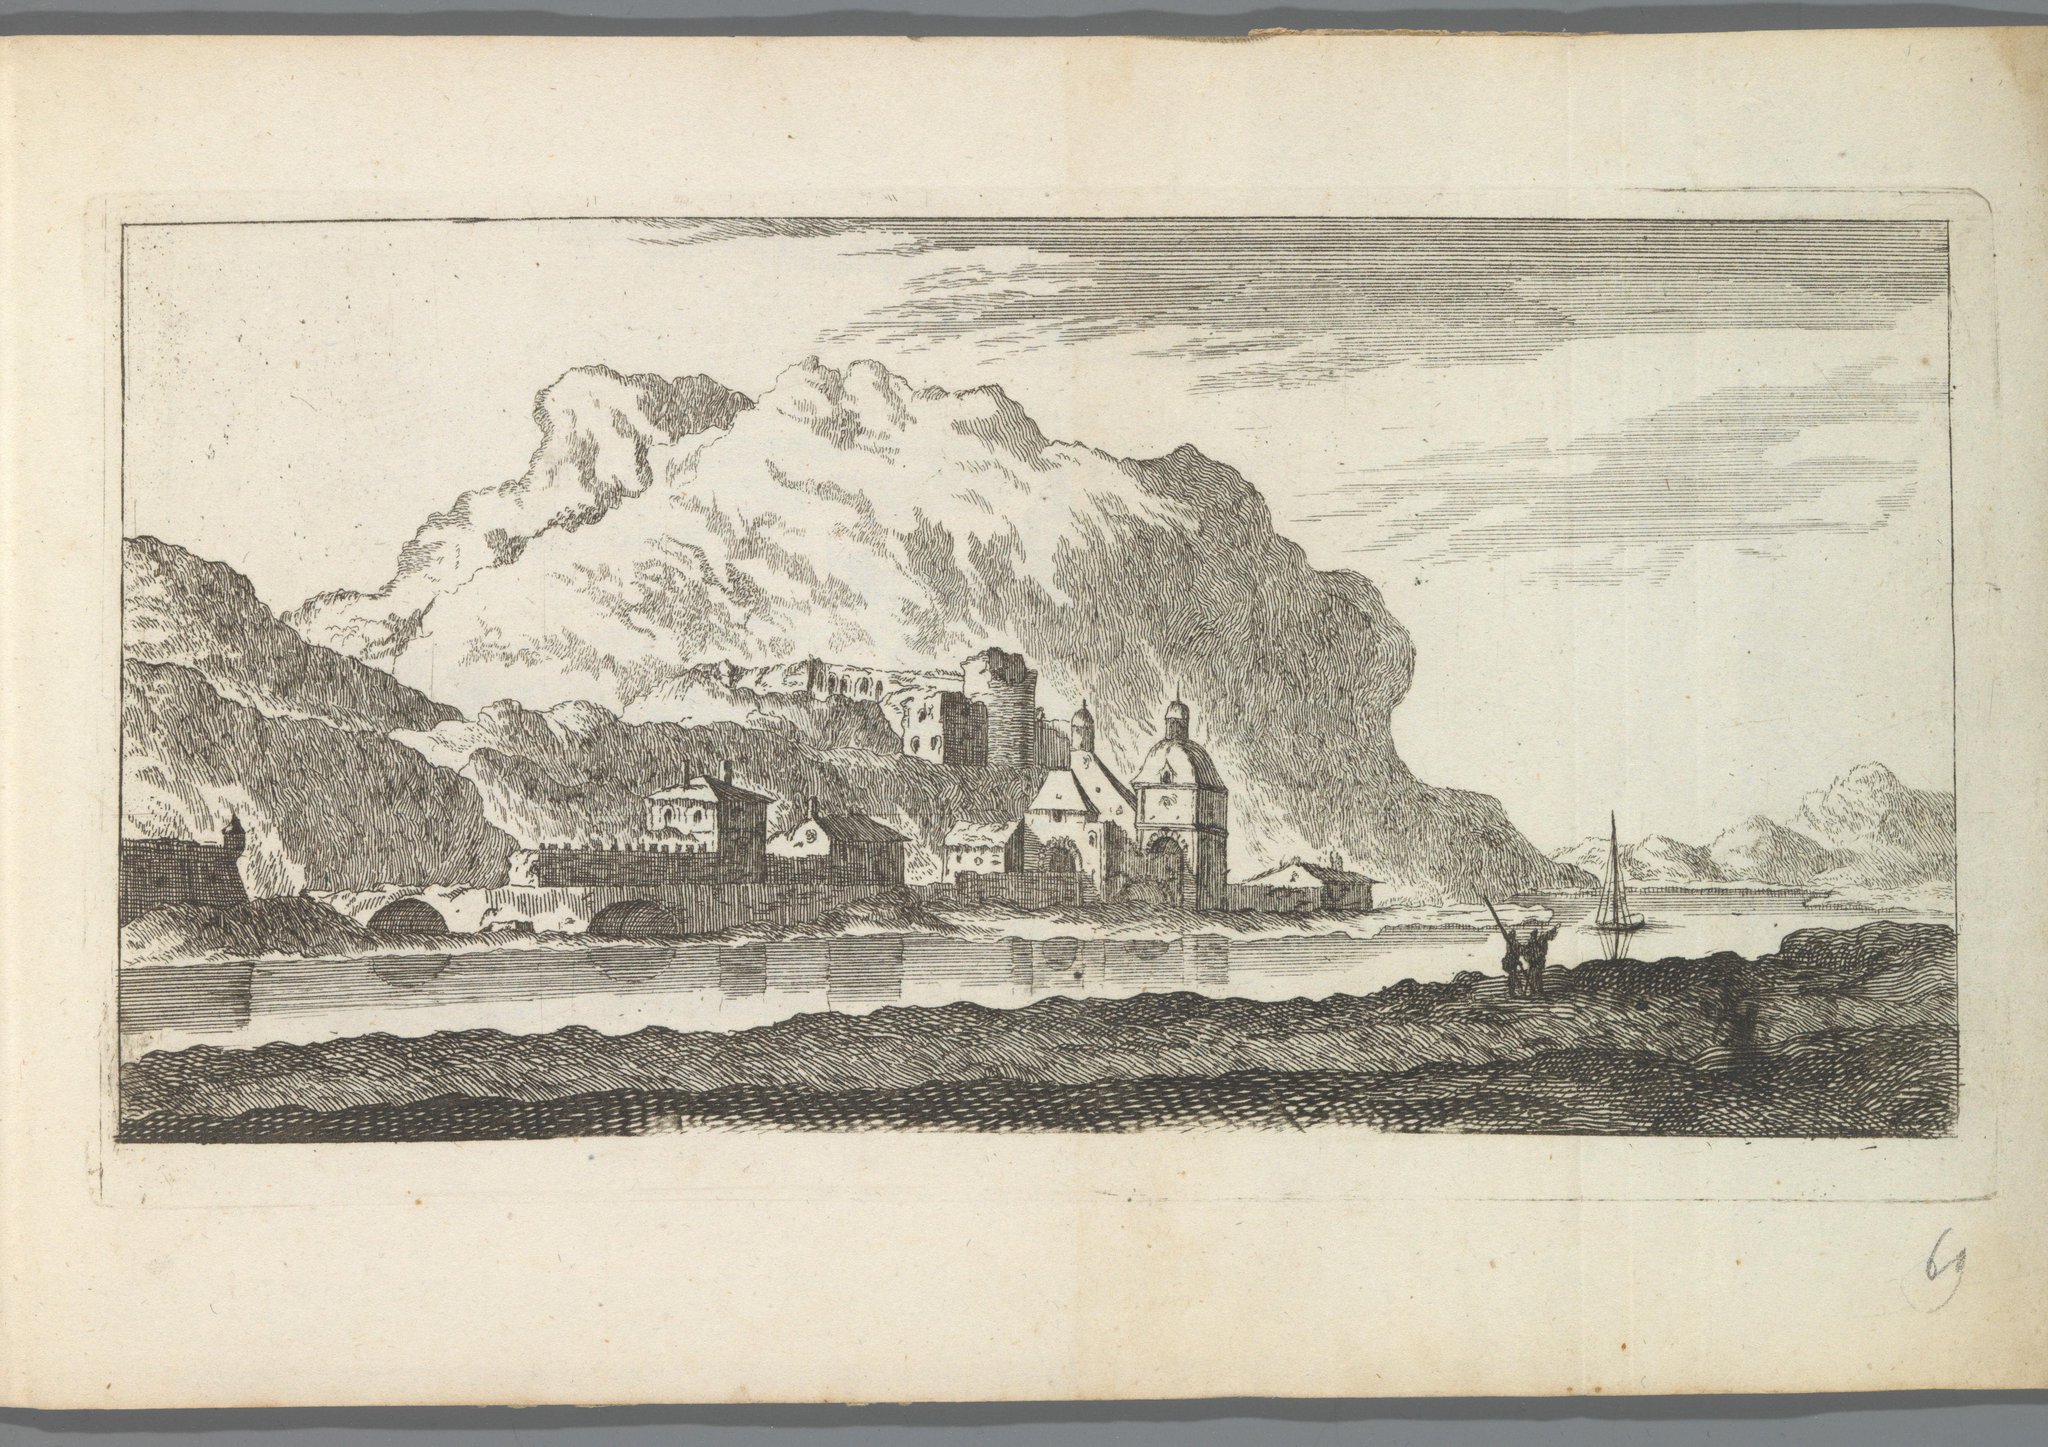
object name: print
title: Berglandschap met gebouwen aan een rivier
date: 1600-1699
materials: paper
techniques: etching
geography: amsterdam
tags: landscapes, river, mountains - hh - ideal landscapes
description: Berglandschap met een rivier. Tegen de rotswand enkele gebouwen. De prent maakt deel uit van een album.